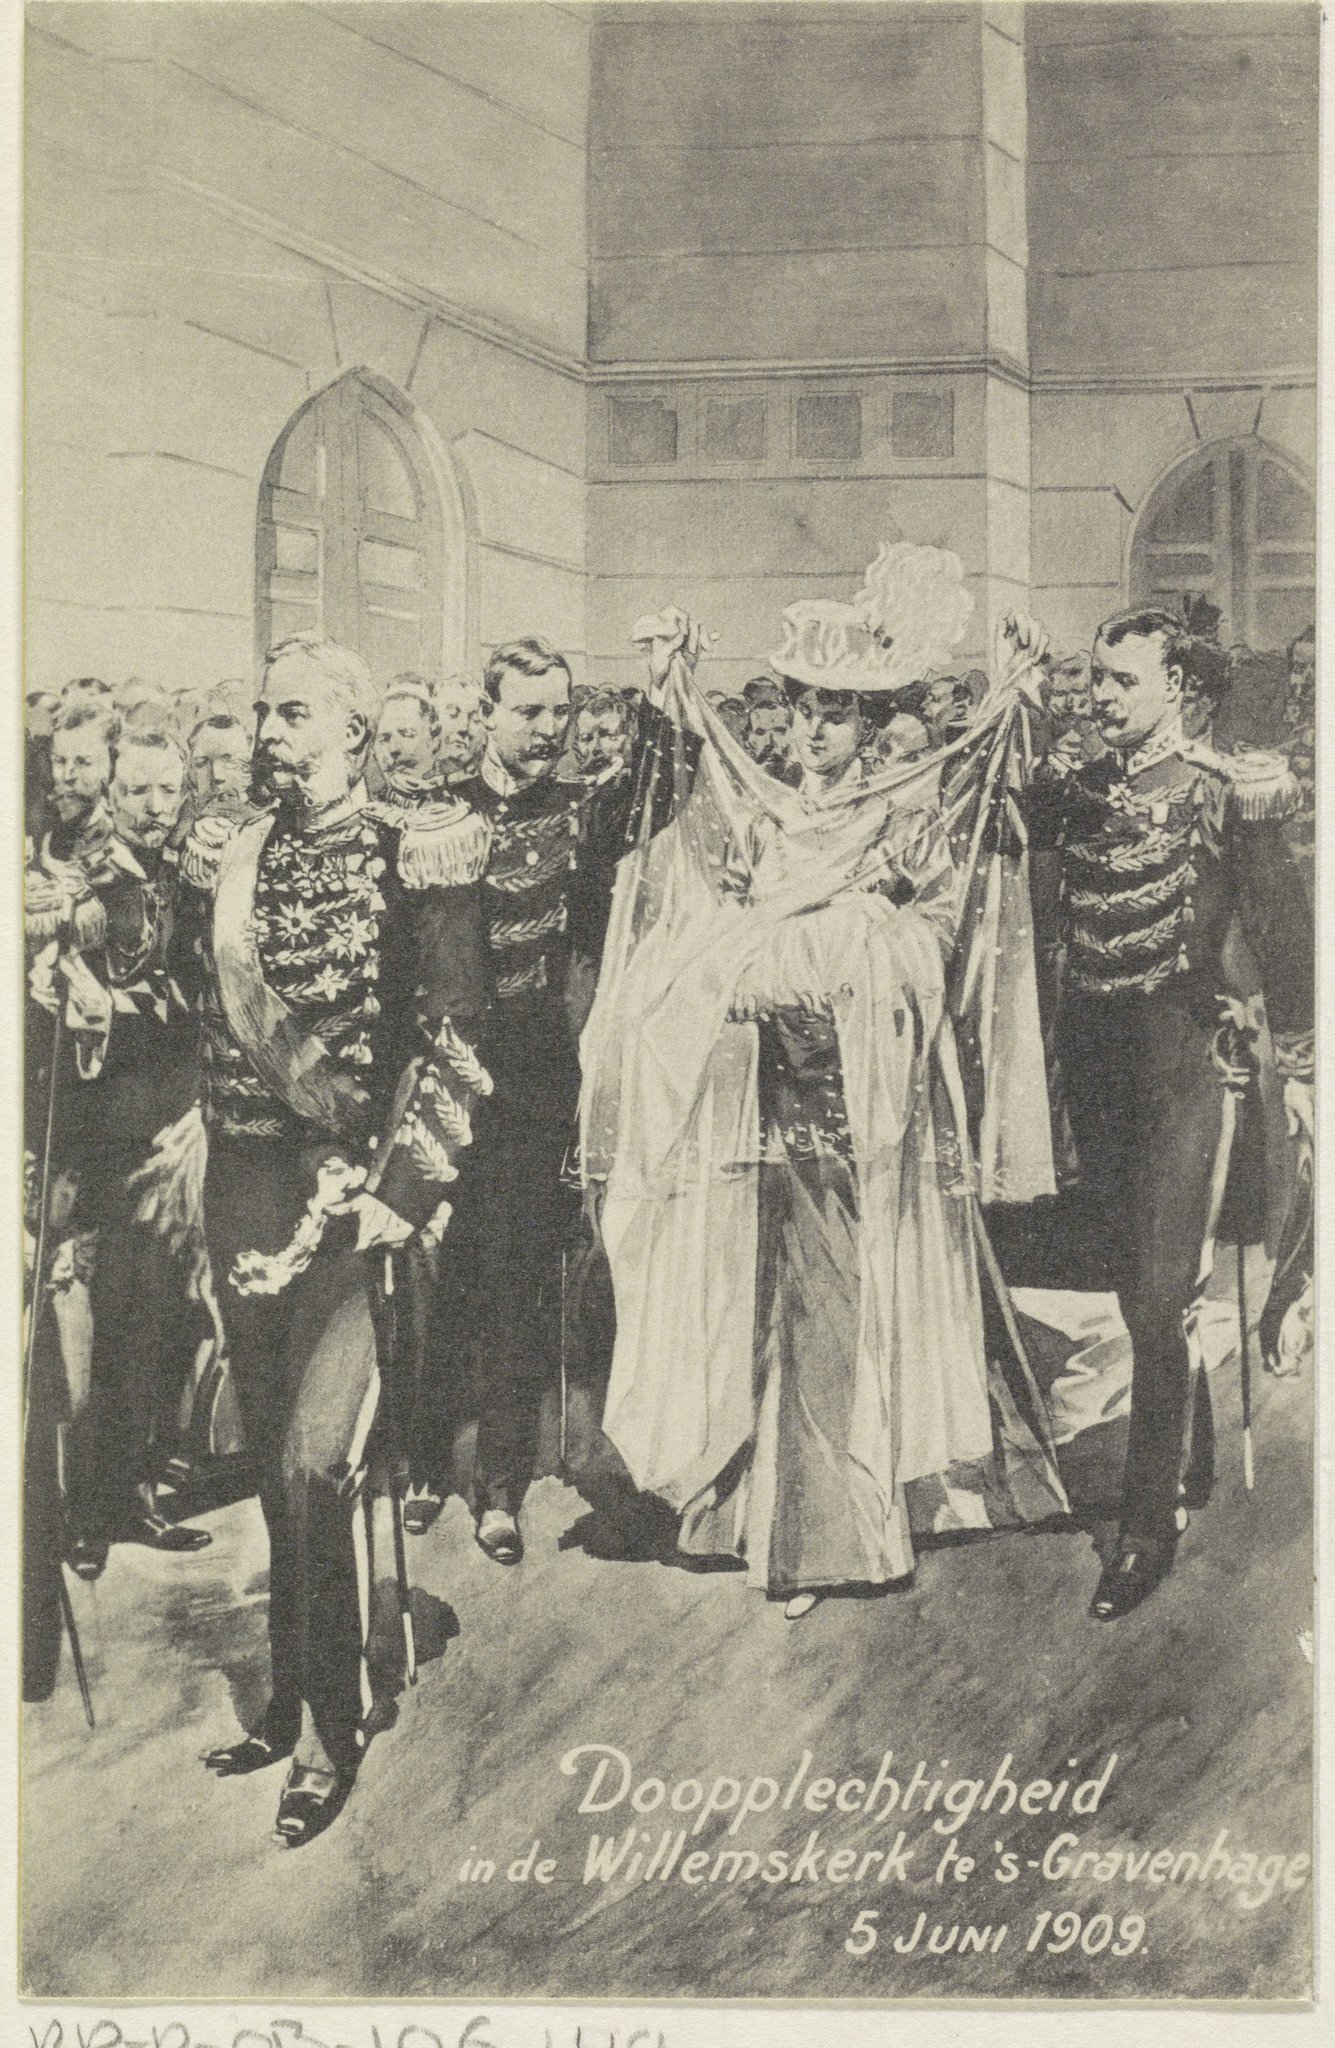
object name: photomechanical print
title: Doop van Juliana, koningin der Nederlanden, in de Willemskerk te Den Haag op 5 juni 1909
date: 1909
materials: paper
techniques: photograph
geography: the hague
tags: print maker, wilhelmina of the netherlands, hendrik (prins der nederlanden (1876-1934)), juliana of the netherlands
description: De hier vermelde titel verwijst naar de hoogst verkregen titel van de geportretteerde, niet per se naar de titel die de geportretteerde op deze voorstelling draagt.